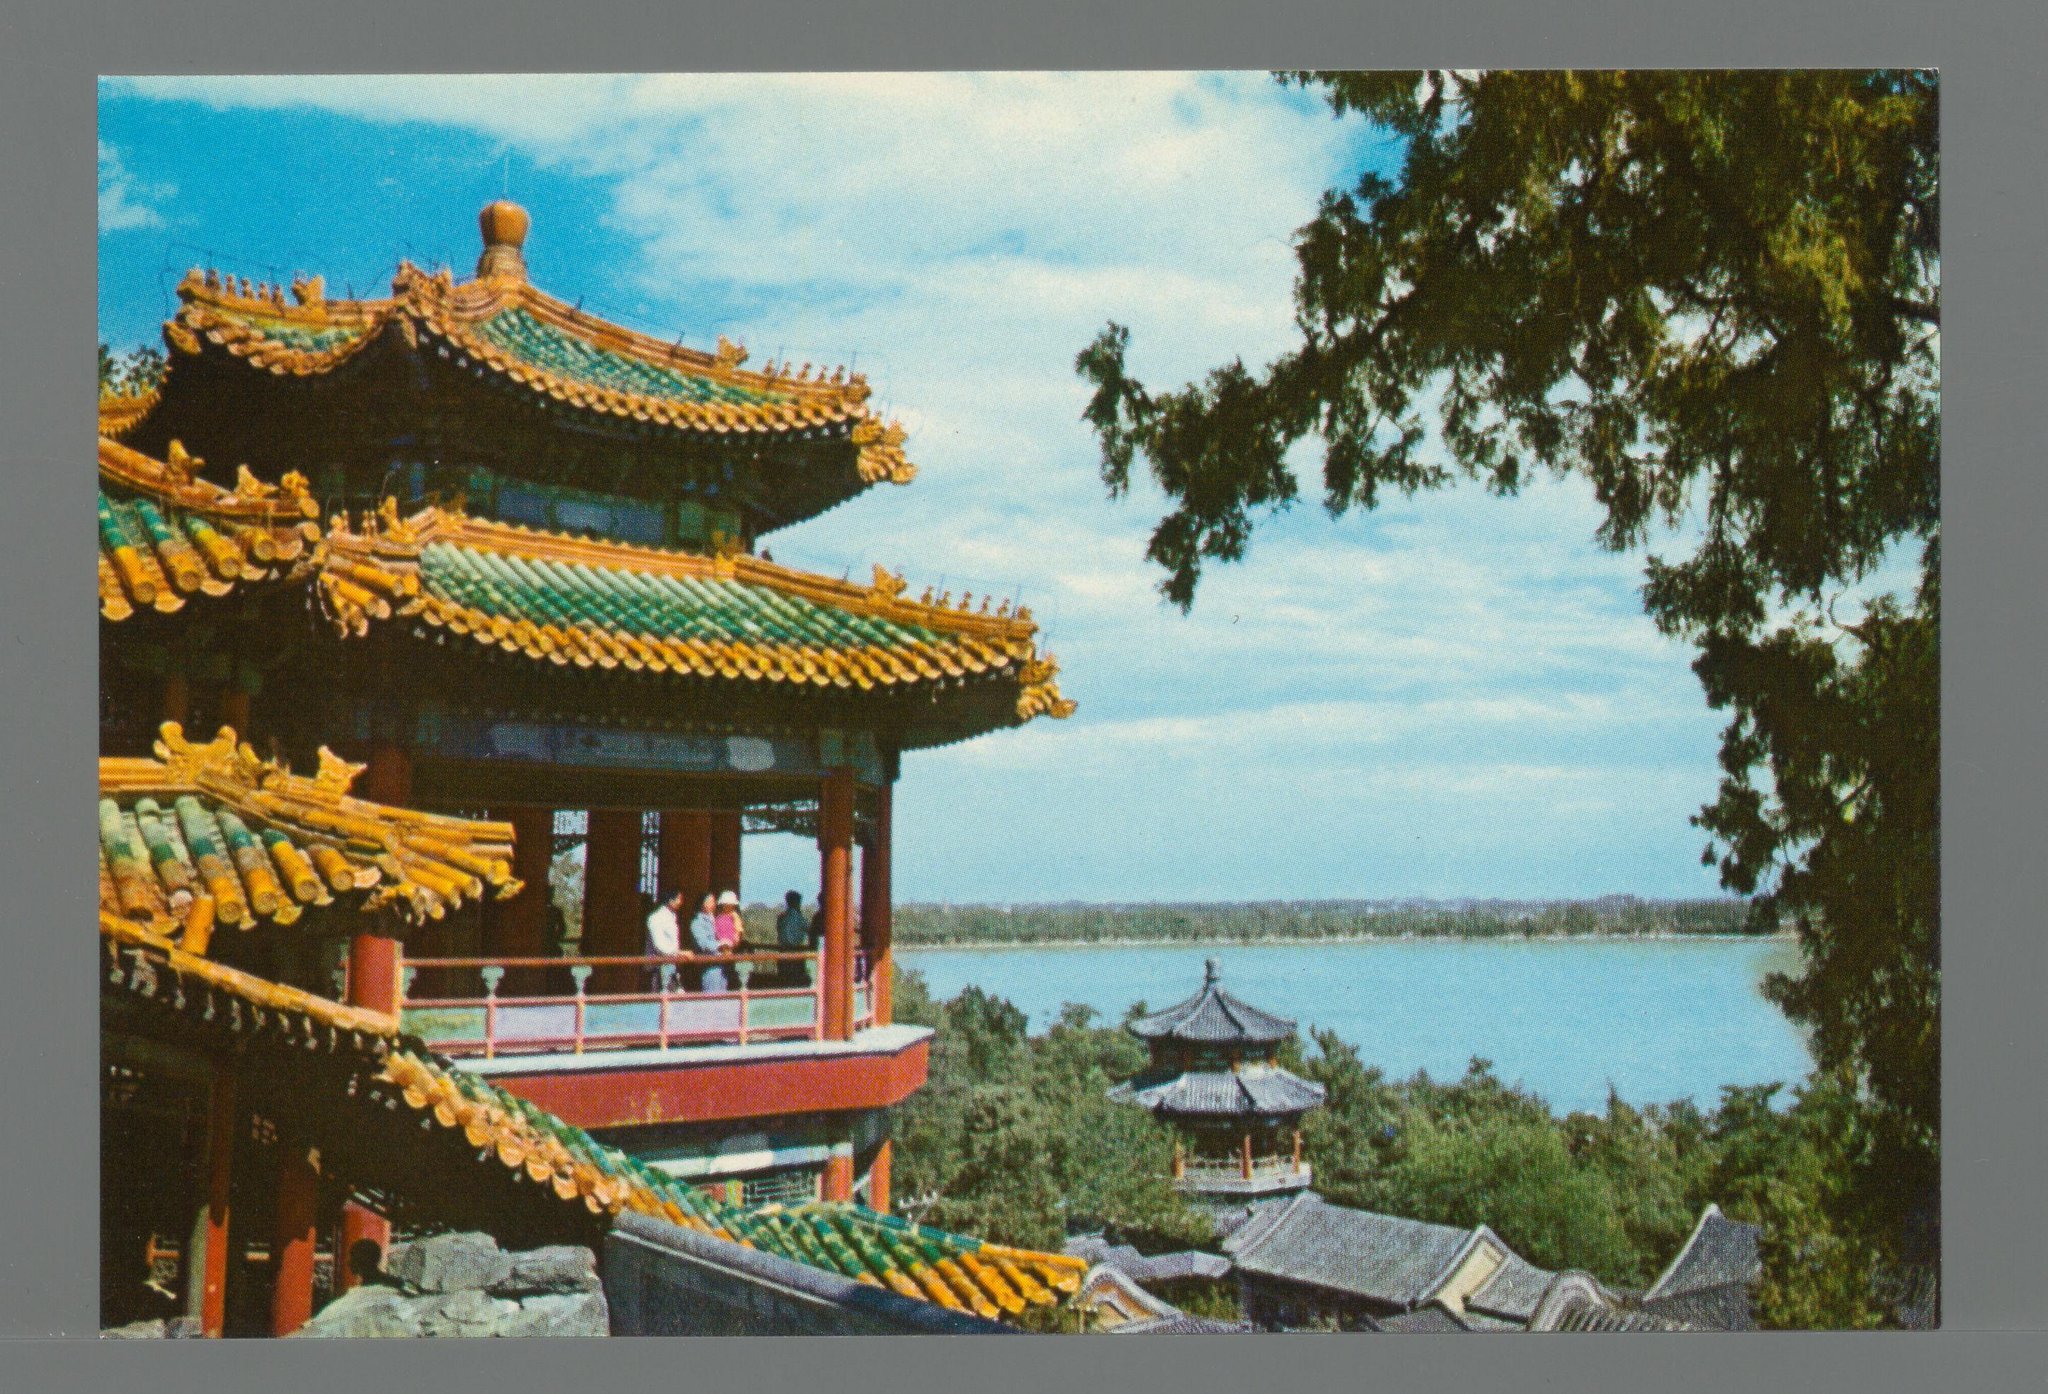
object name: ansichtkaart, prentbriefkaart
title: The Summer Palace, Peking / Vues du Palais d'Eté de Pékin / Vista del Palacio de Verano, Pekin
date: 1974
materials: cardboard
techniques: offset printed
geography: china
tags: palace, avenue, boulevard, promenade, esplanade